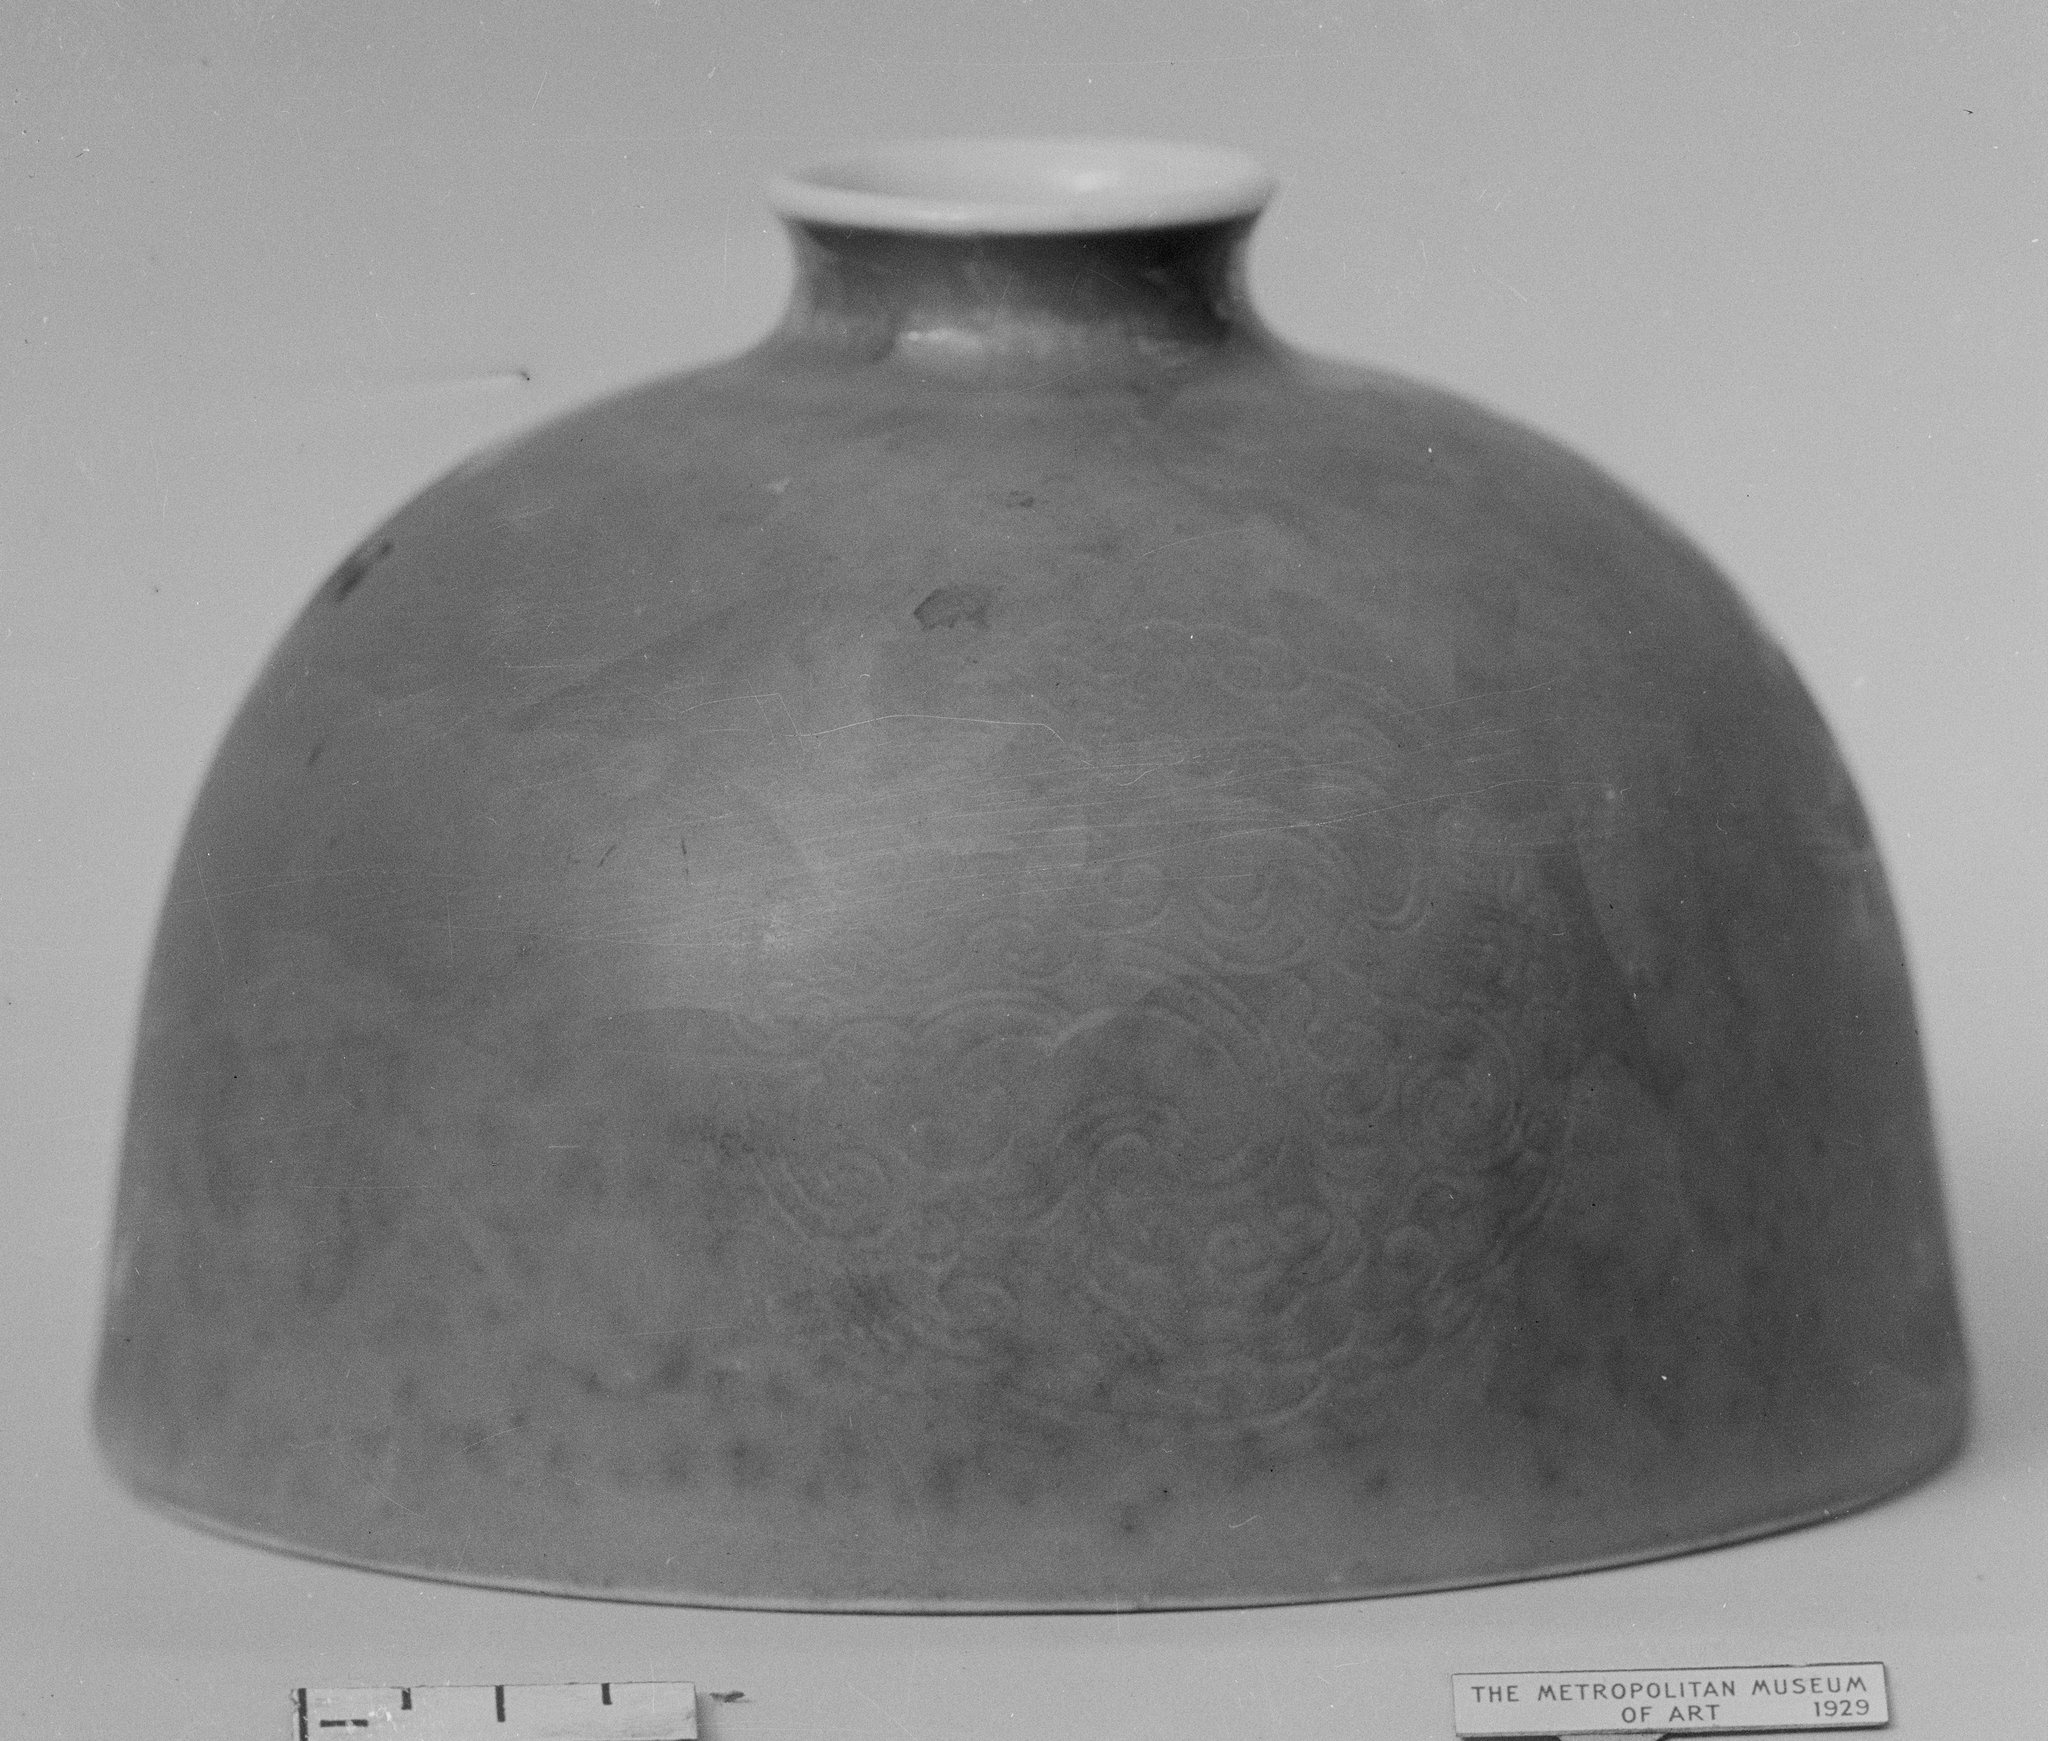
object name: water coupe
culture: chinese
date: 1662-1722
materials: glaze, porcelain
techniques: incising